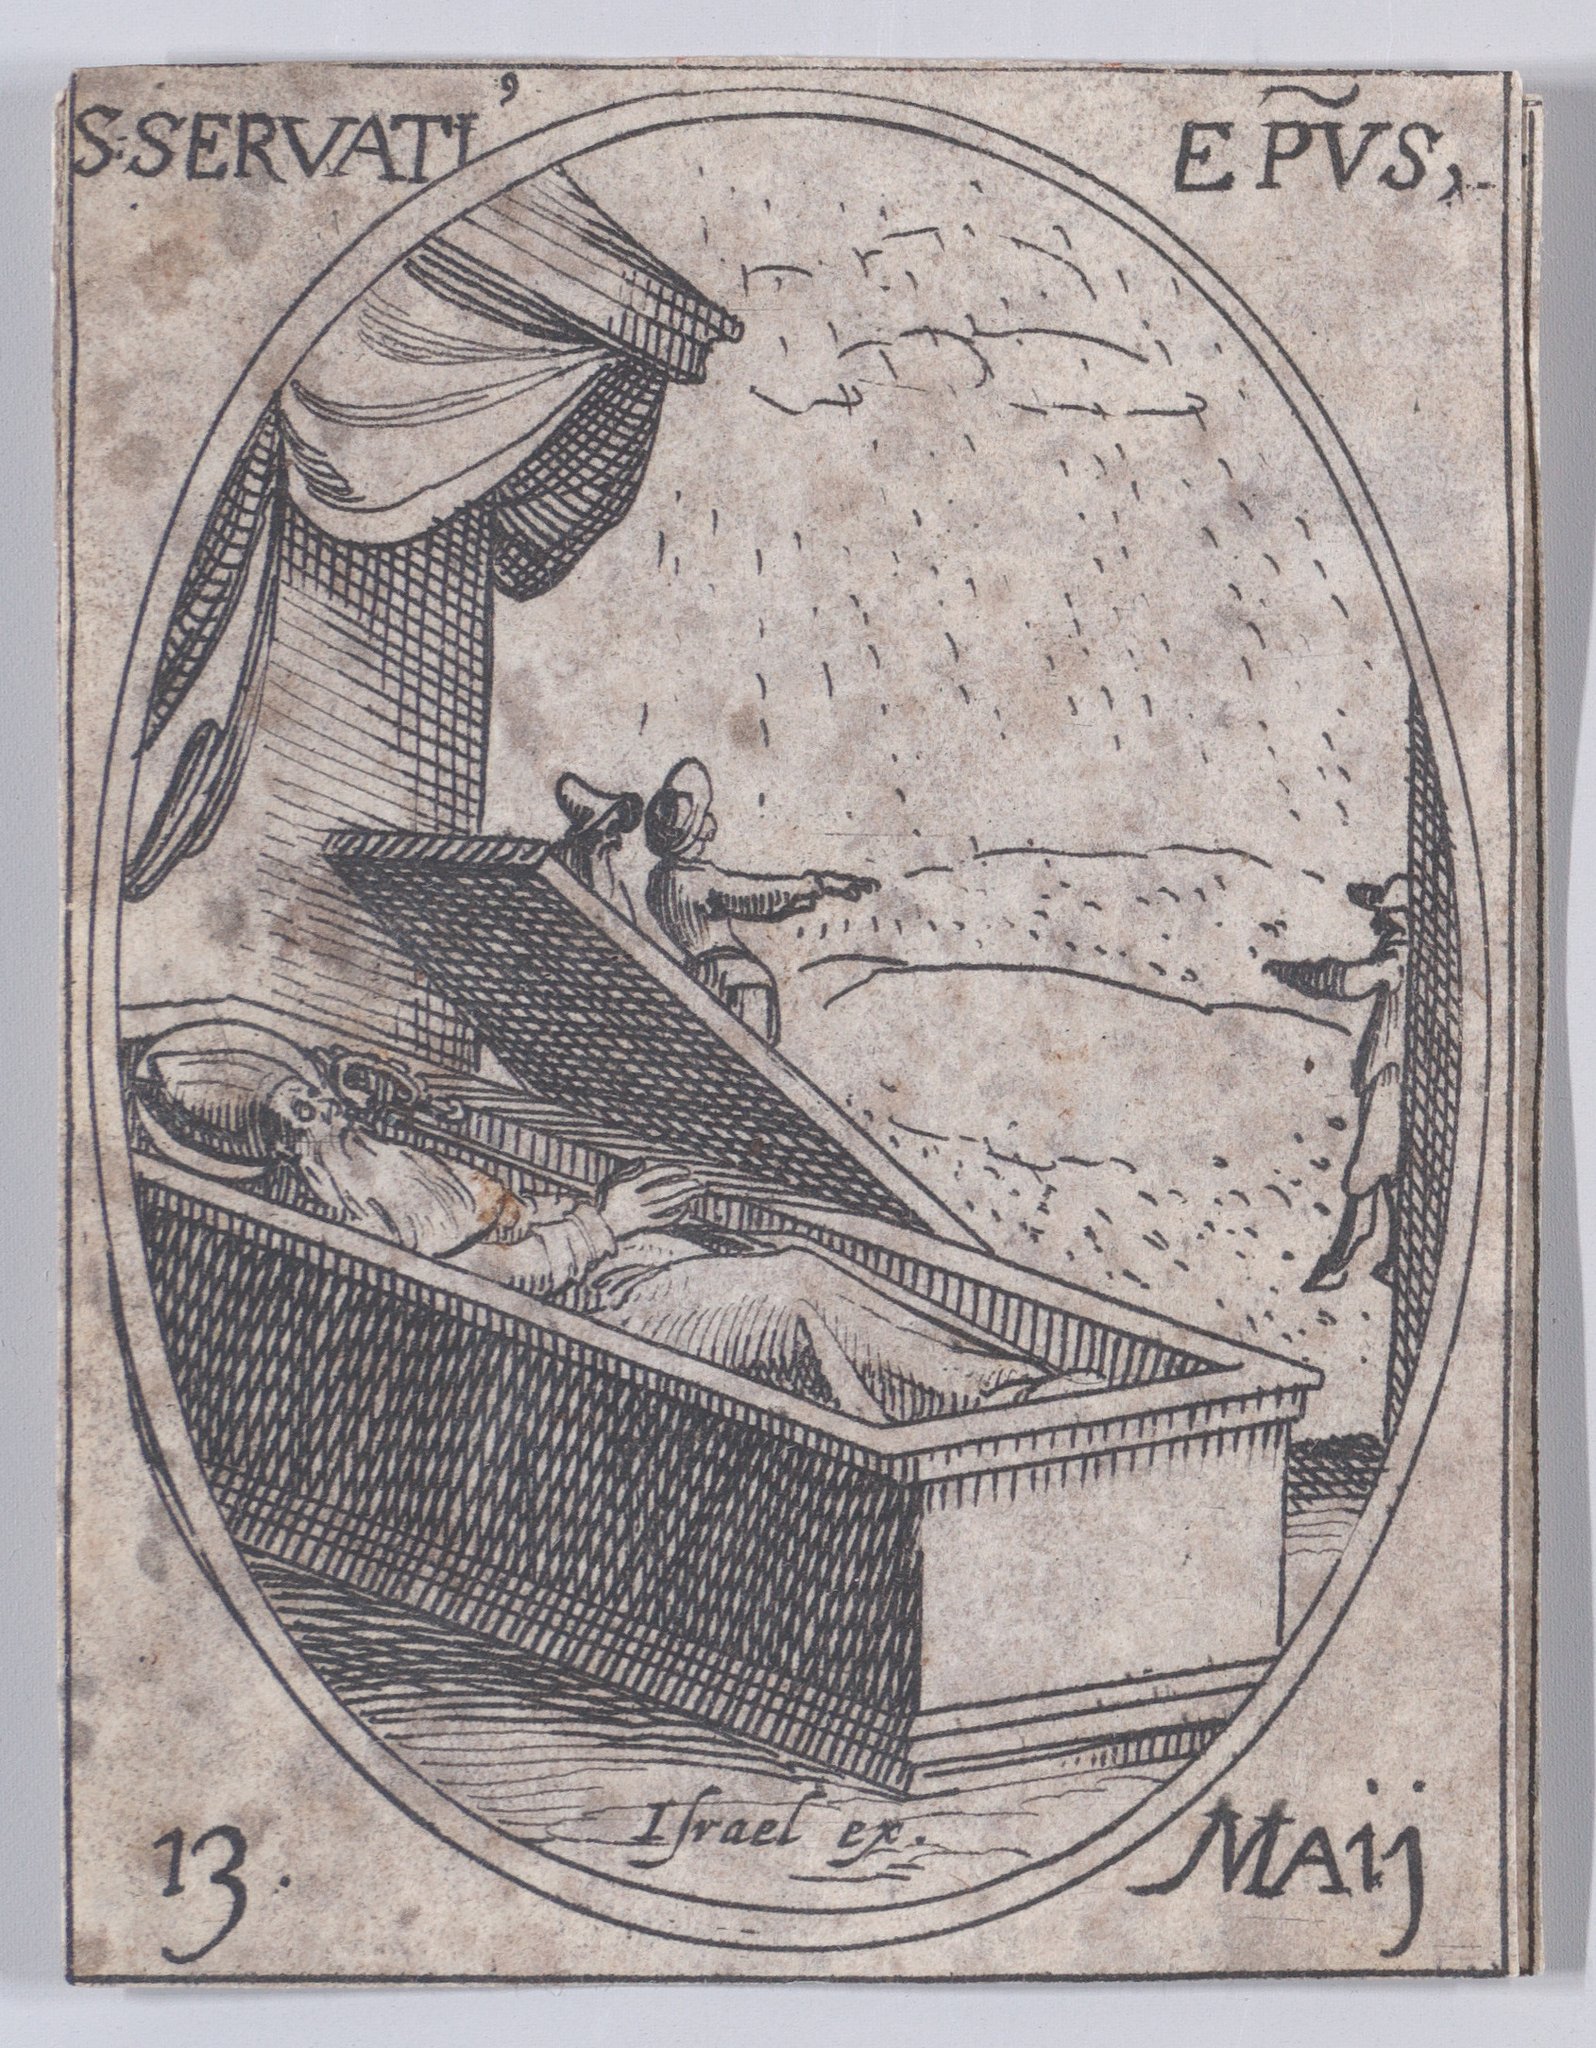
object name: print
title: S. Servais, évêque (St. Servatus, Bishop), May 13th, from "Les Images De Tous Les Saincts et Saintes de L'Année" (Images of All of the Saints and Religious Events of the Year)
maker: jacques callot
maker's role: artist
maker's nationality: french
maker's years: 1592-1635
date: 1636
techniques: etching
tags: men,saints